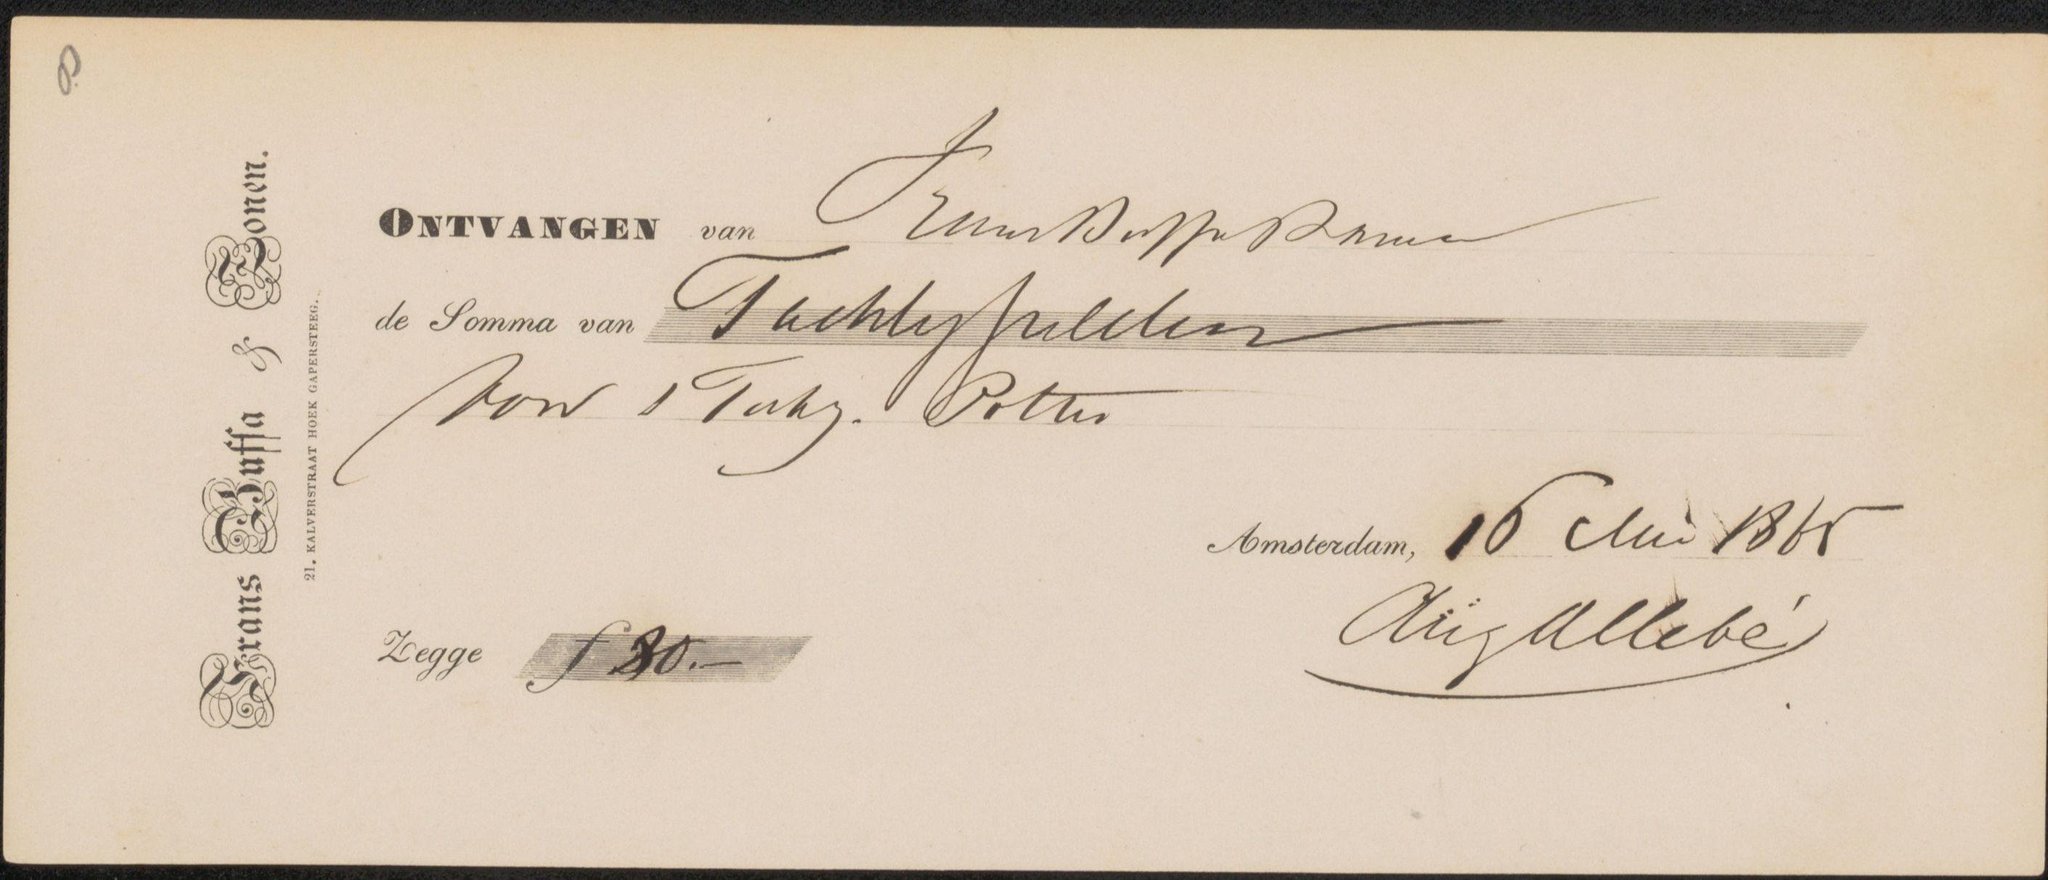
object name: ontvangstbewijs, kwitantie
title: Kwitantie voor August Allebé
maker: august allebé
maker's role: draughtsman, print maker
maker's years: 1838-1927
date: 1865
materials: ink, paper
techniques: pen, printing, writing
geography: amsterdam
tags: art trade, art shop, drawing, money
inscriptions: collector's mark: Lugt 2233